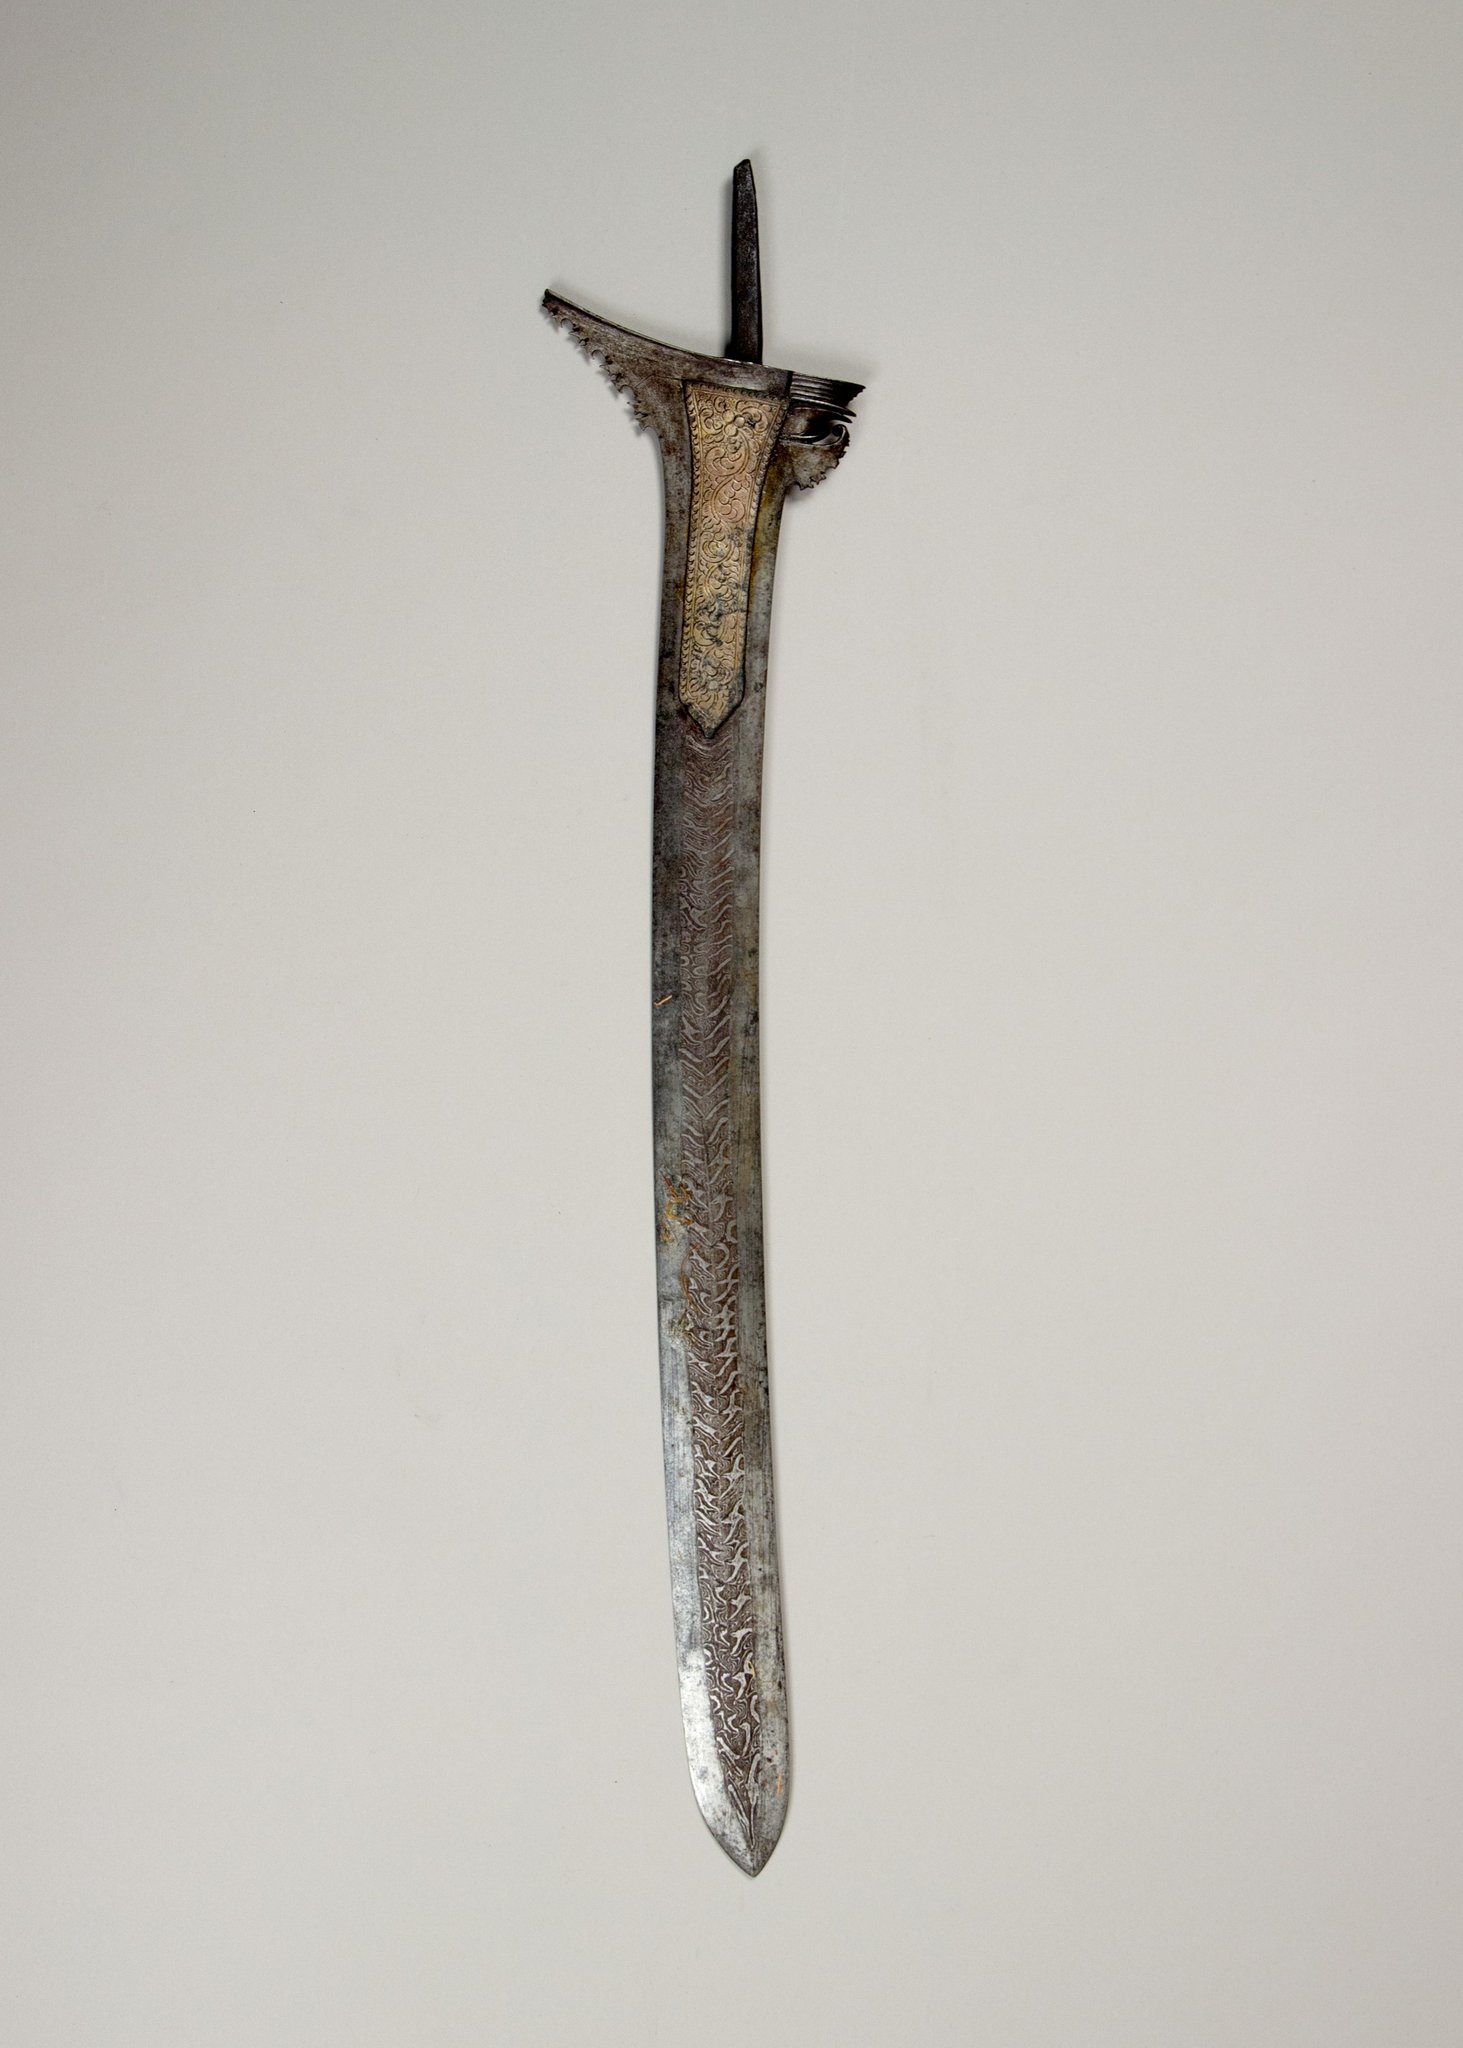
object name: blade for a kris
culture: philippine, moro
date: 1701-1900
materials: silver, steel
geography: philippines